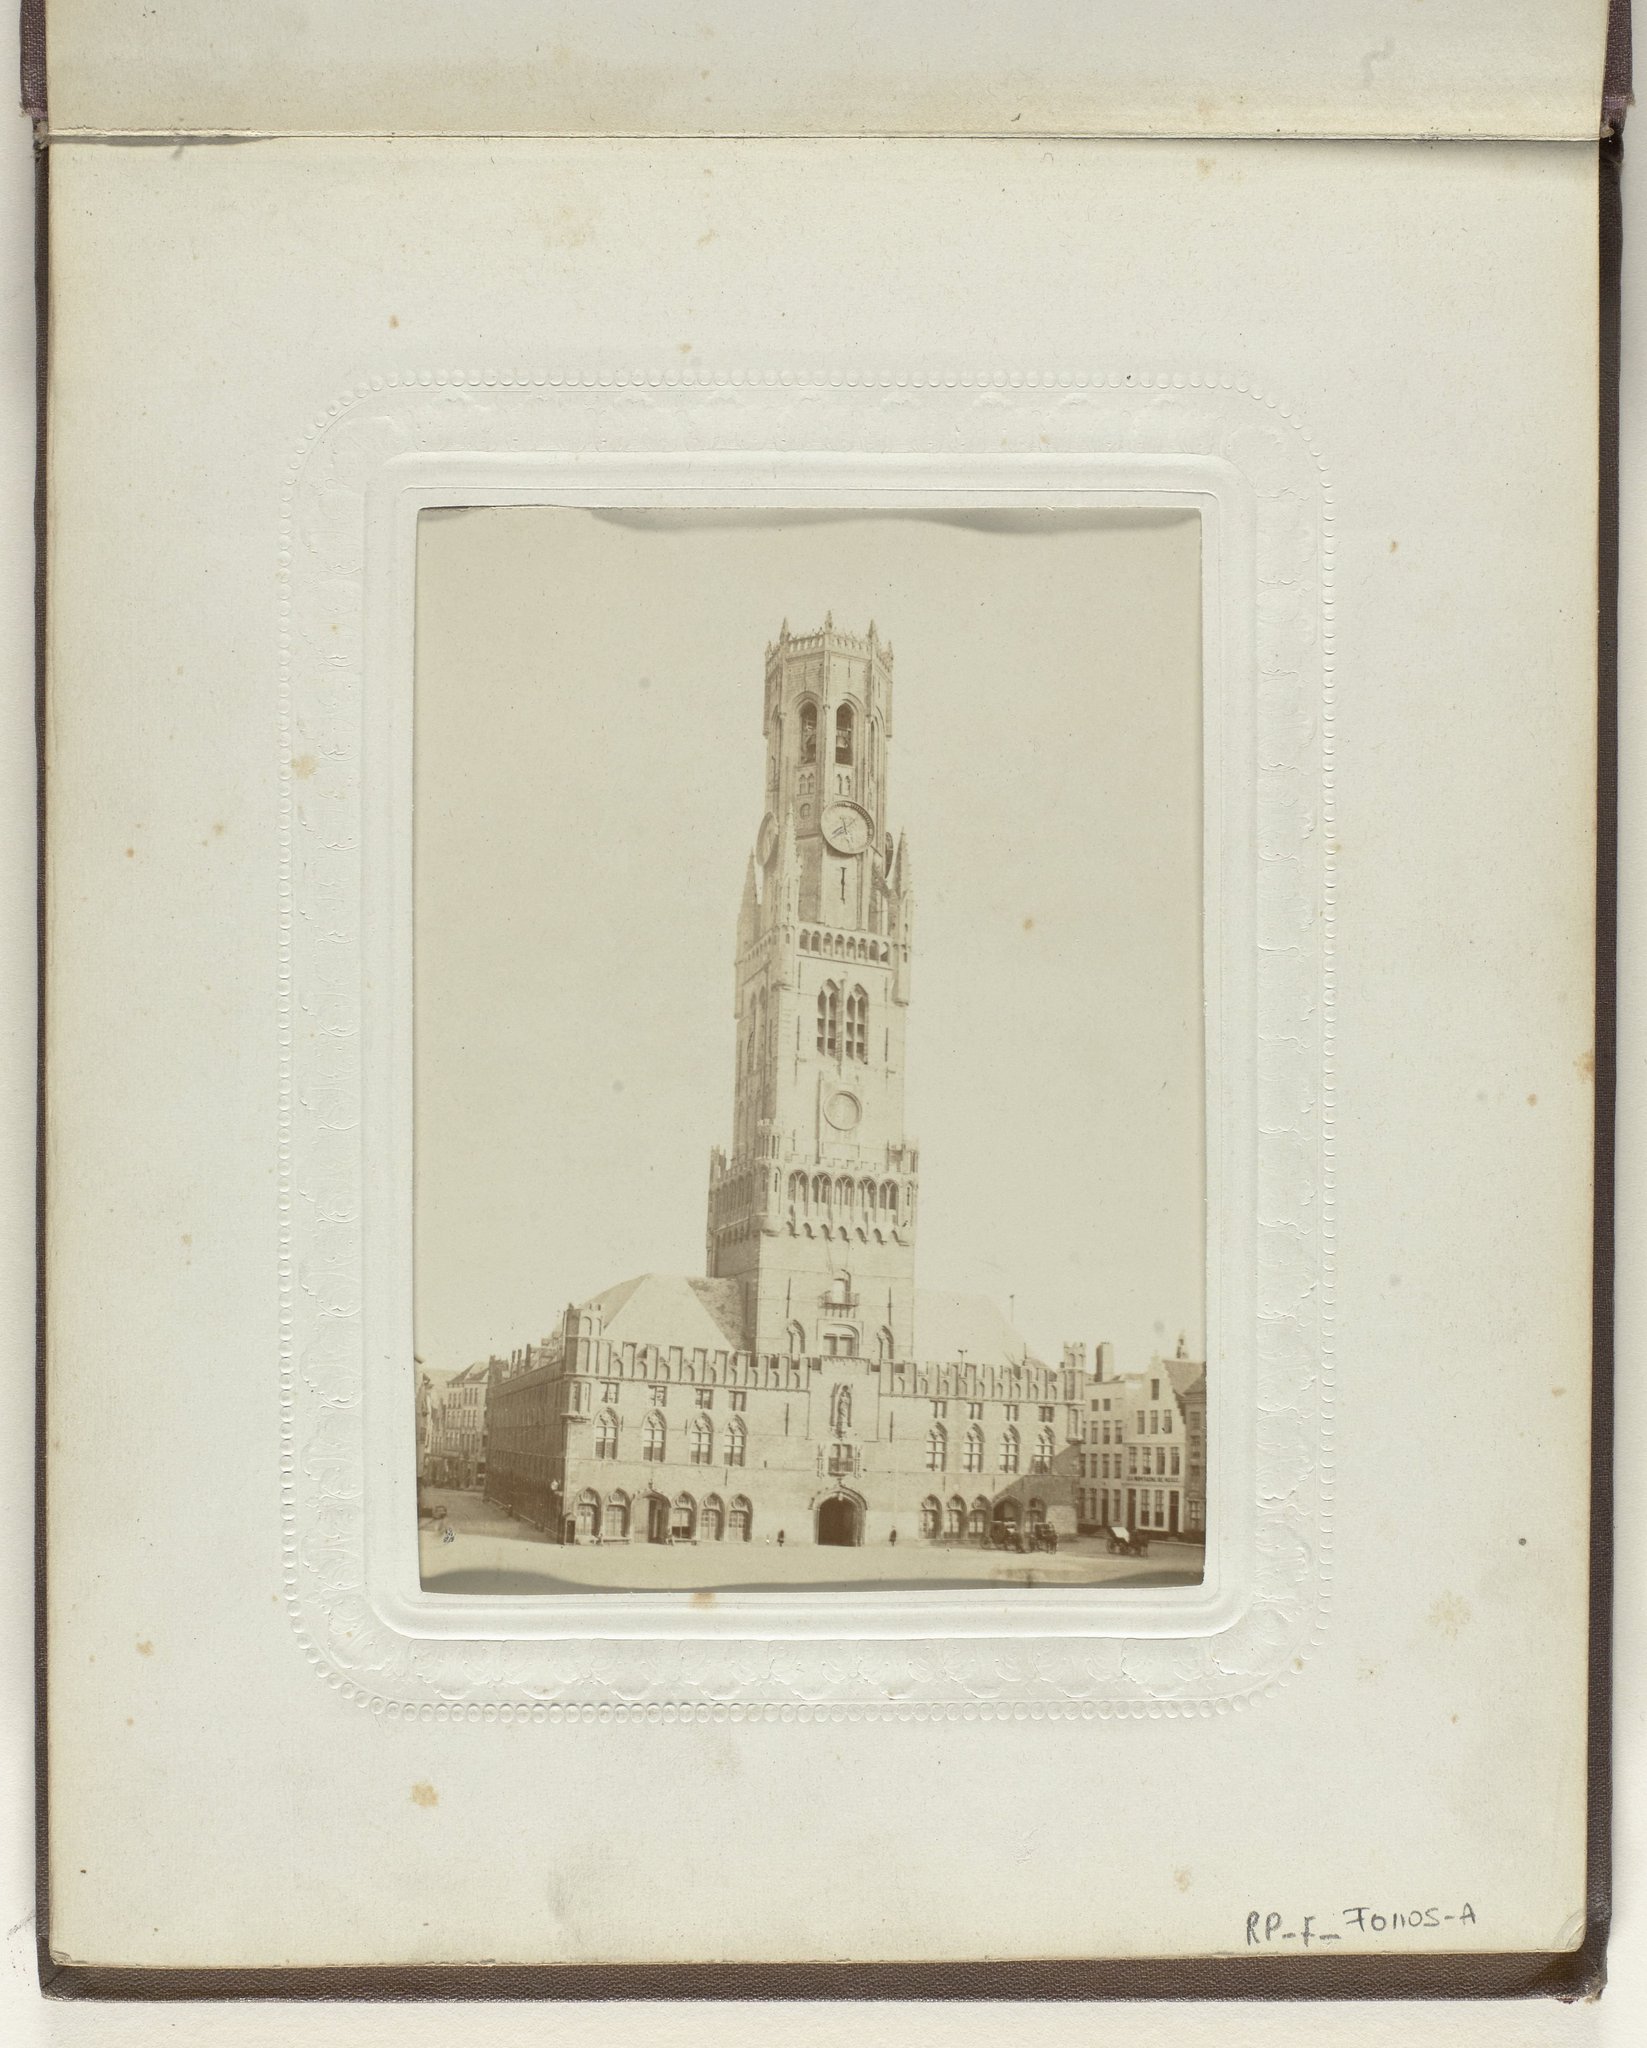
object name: album leaf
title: Gezicht op de stad Brugge bij het Minnewater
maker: victor daveluy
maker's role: fotograaf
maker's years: 1846-1886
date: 1870-1875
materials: paper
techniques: albumen print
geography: bruges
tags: city-view in general; 'veduta', towers ~ fortified city, bridge, parts of church exterior and annexes: tower, bruges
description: Links de Poertoren en rechts daarvan de Minnewaterbrug. Op de achtergrond de Onze-Lieve-Vrouwekerk en rechts daarvan vaag zichtbaar het belfort. Geheel links in de verte de toren van de Sint-Salvatorskathedraal. Deze foto maakt deel uit van een album.